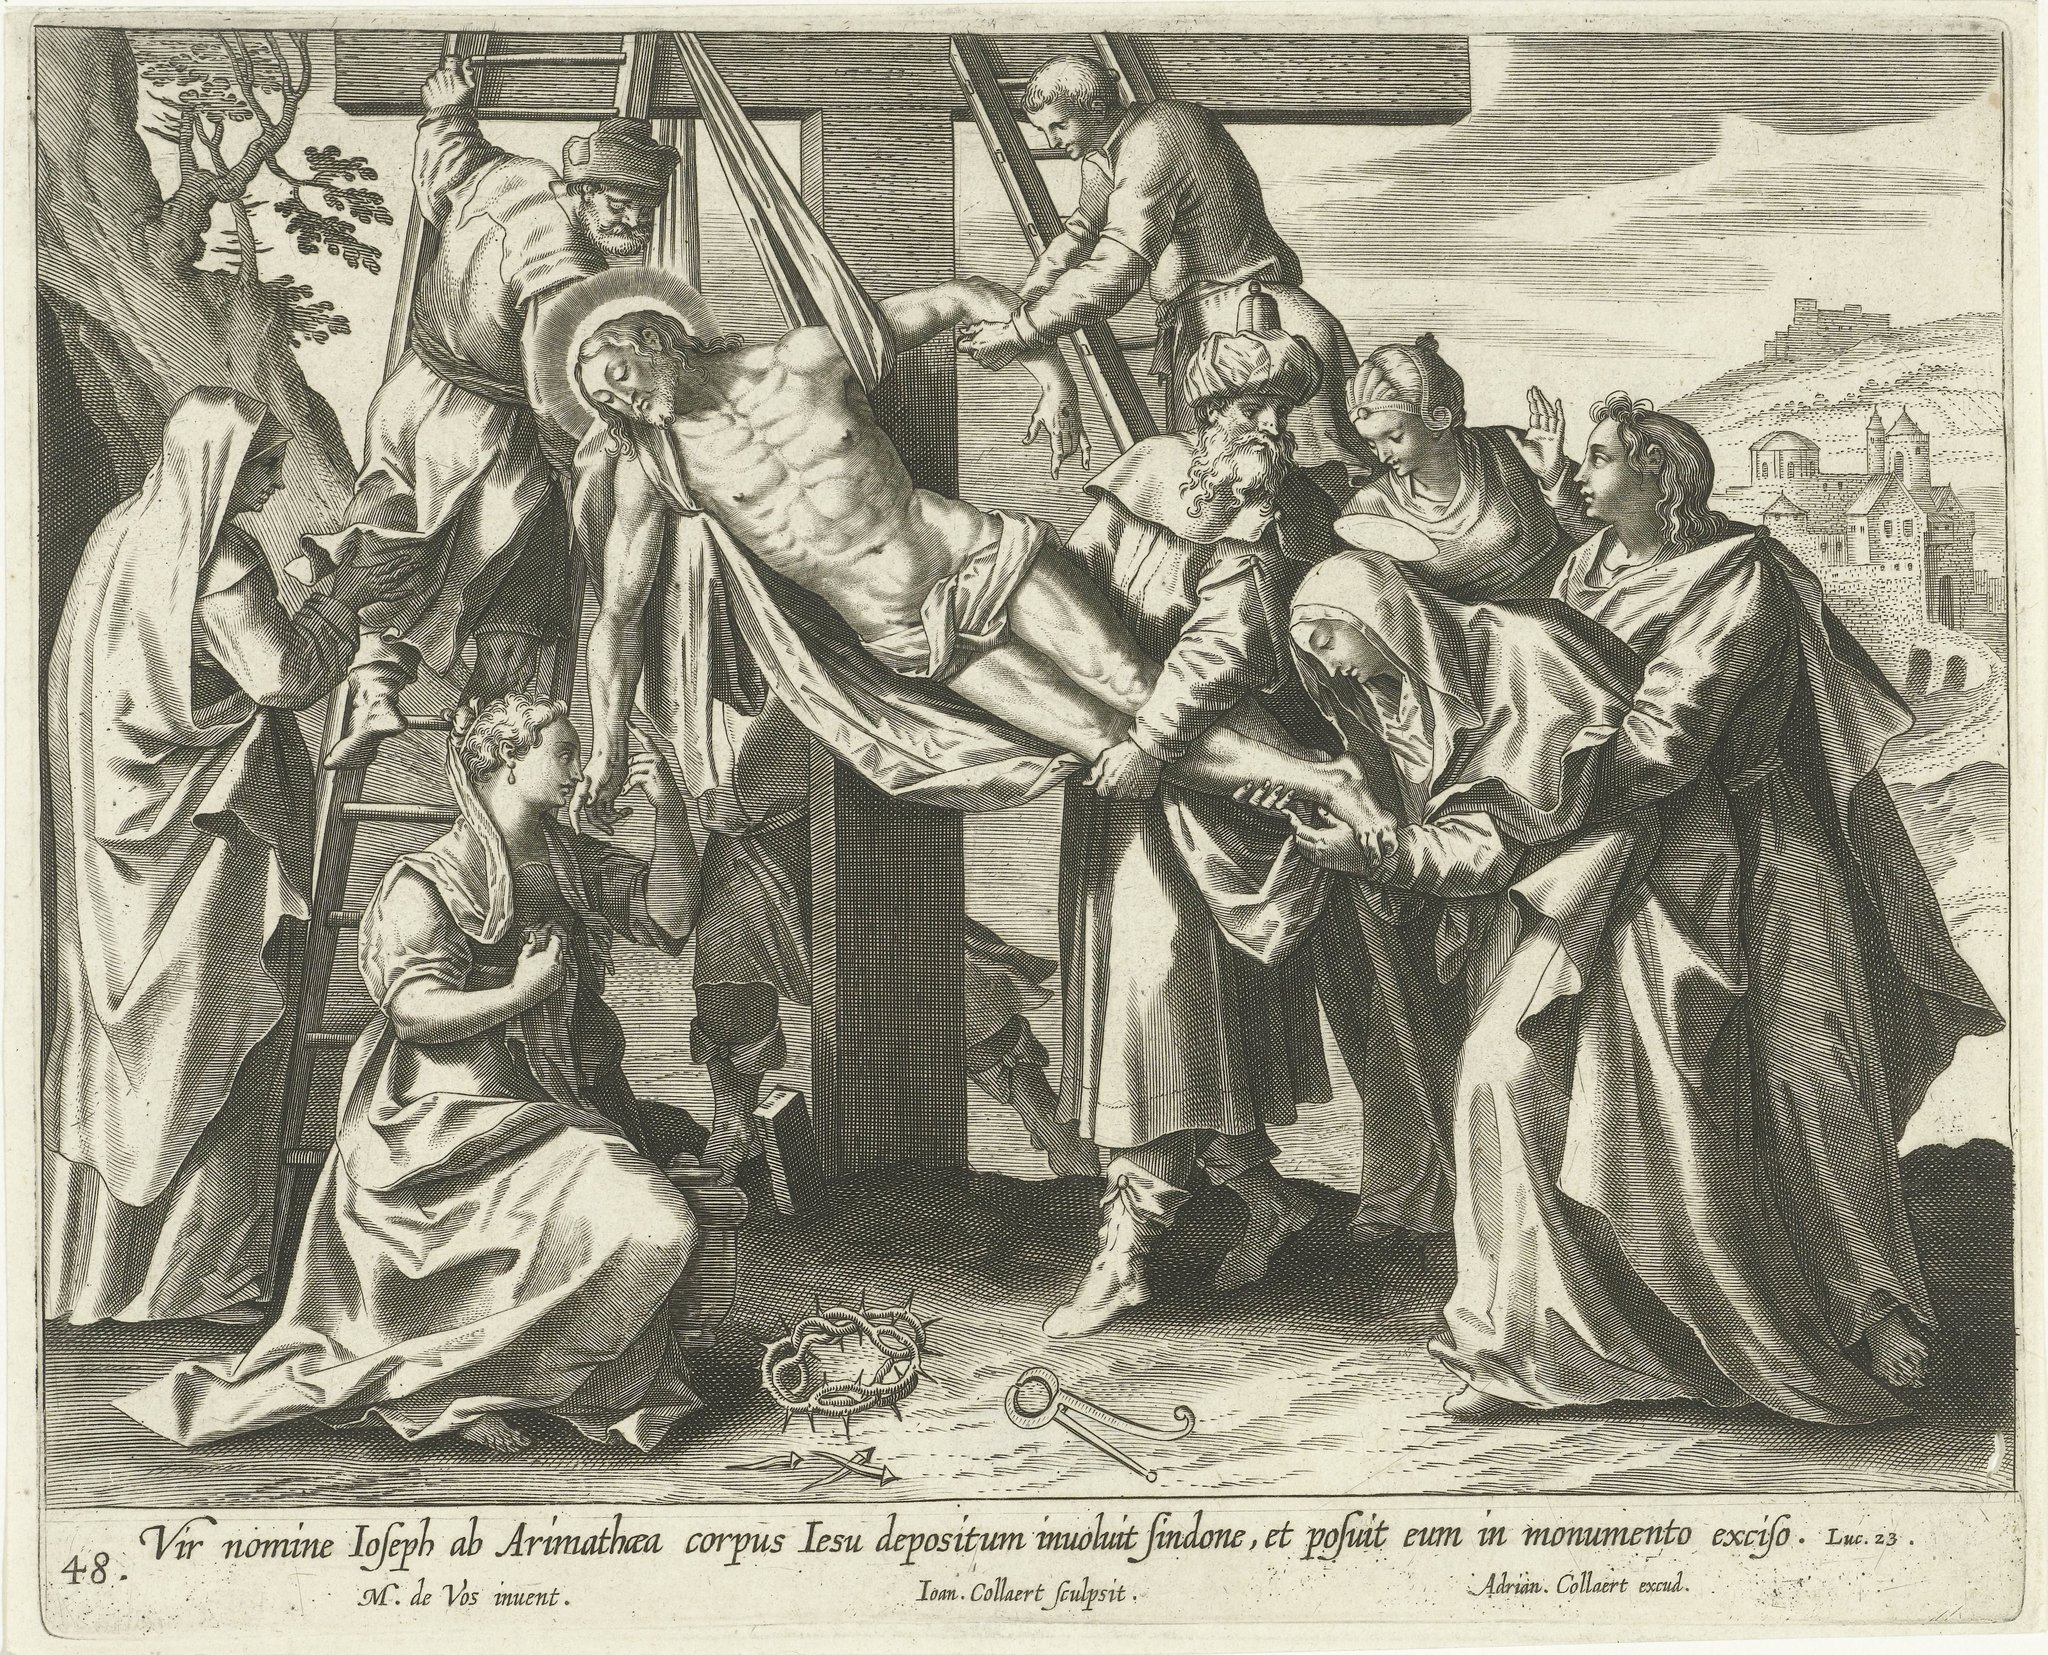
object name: print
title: Leven, passie en wederopstanding van Christus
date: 1598-1618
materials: paper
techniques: engraving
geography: antwerp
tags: descent from the cross: christ is taken down from the cross, usually by nicodemus and joseph of arimathaea who are standing on the ladders (both arms of christ detached)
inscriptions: collector's mark: Lugt 2228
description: Christus wordt het kruis afgenomen door Jozef van Arimatea, Nikodemus en Johannes. Maria, Maria Magdalena en twee andere vrouwen helpen (Lucs 23:53). De prent heeft een Latijns onderschrift. De prent maakt deel uit van een serie over het leven van Christus.